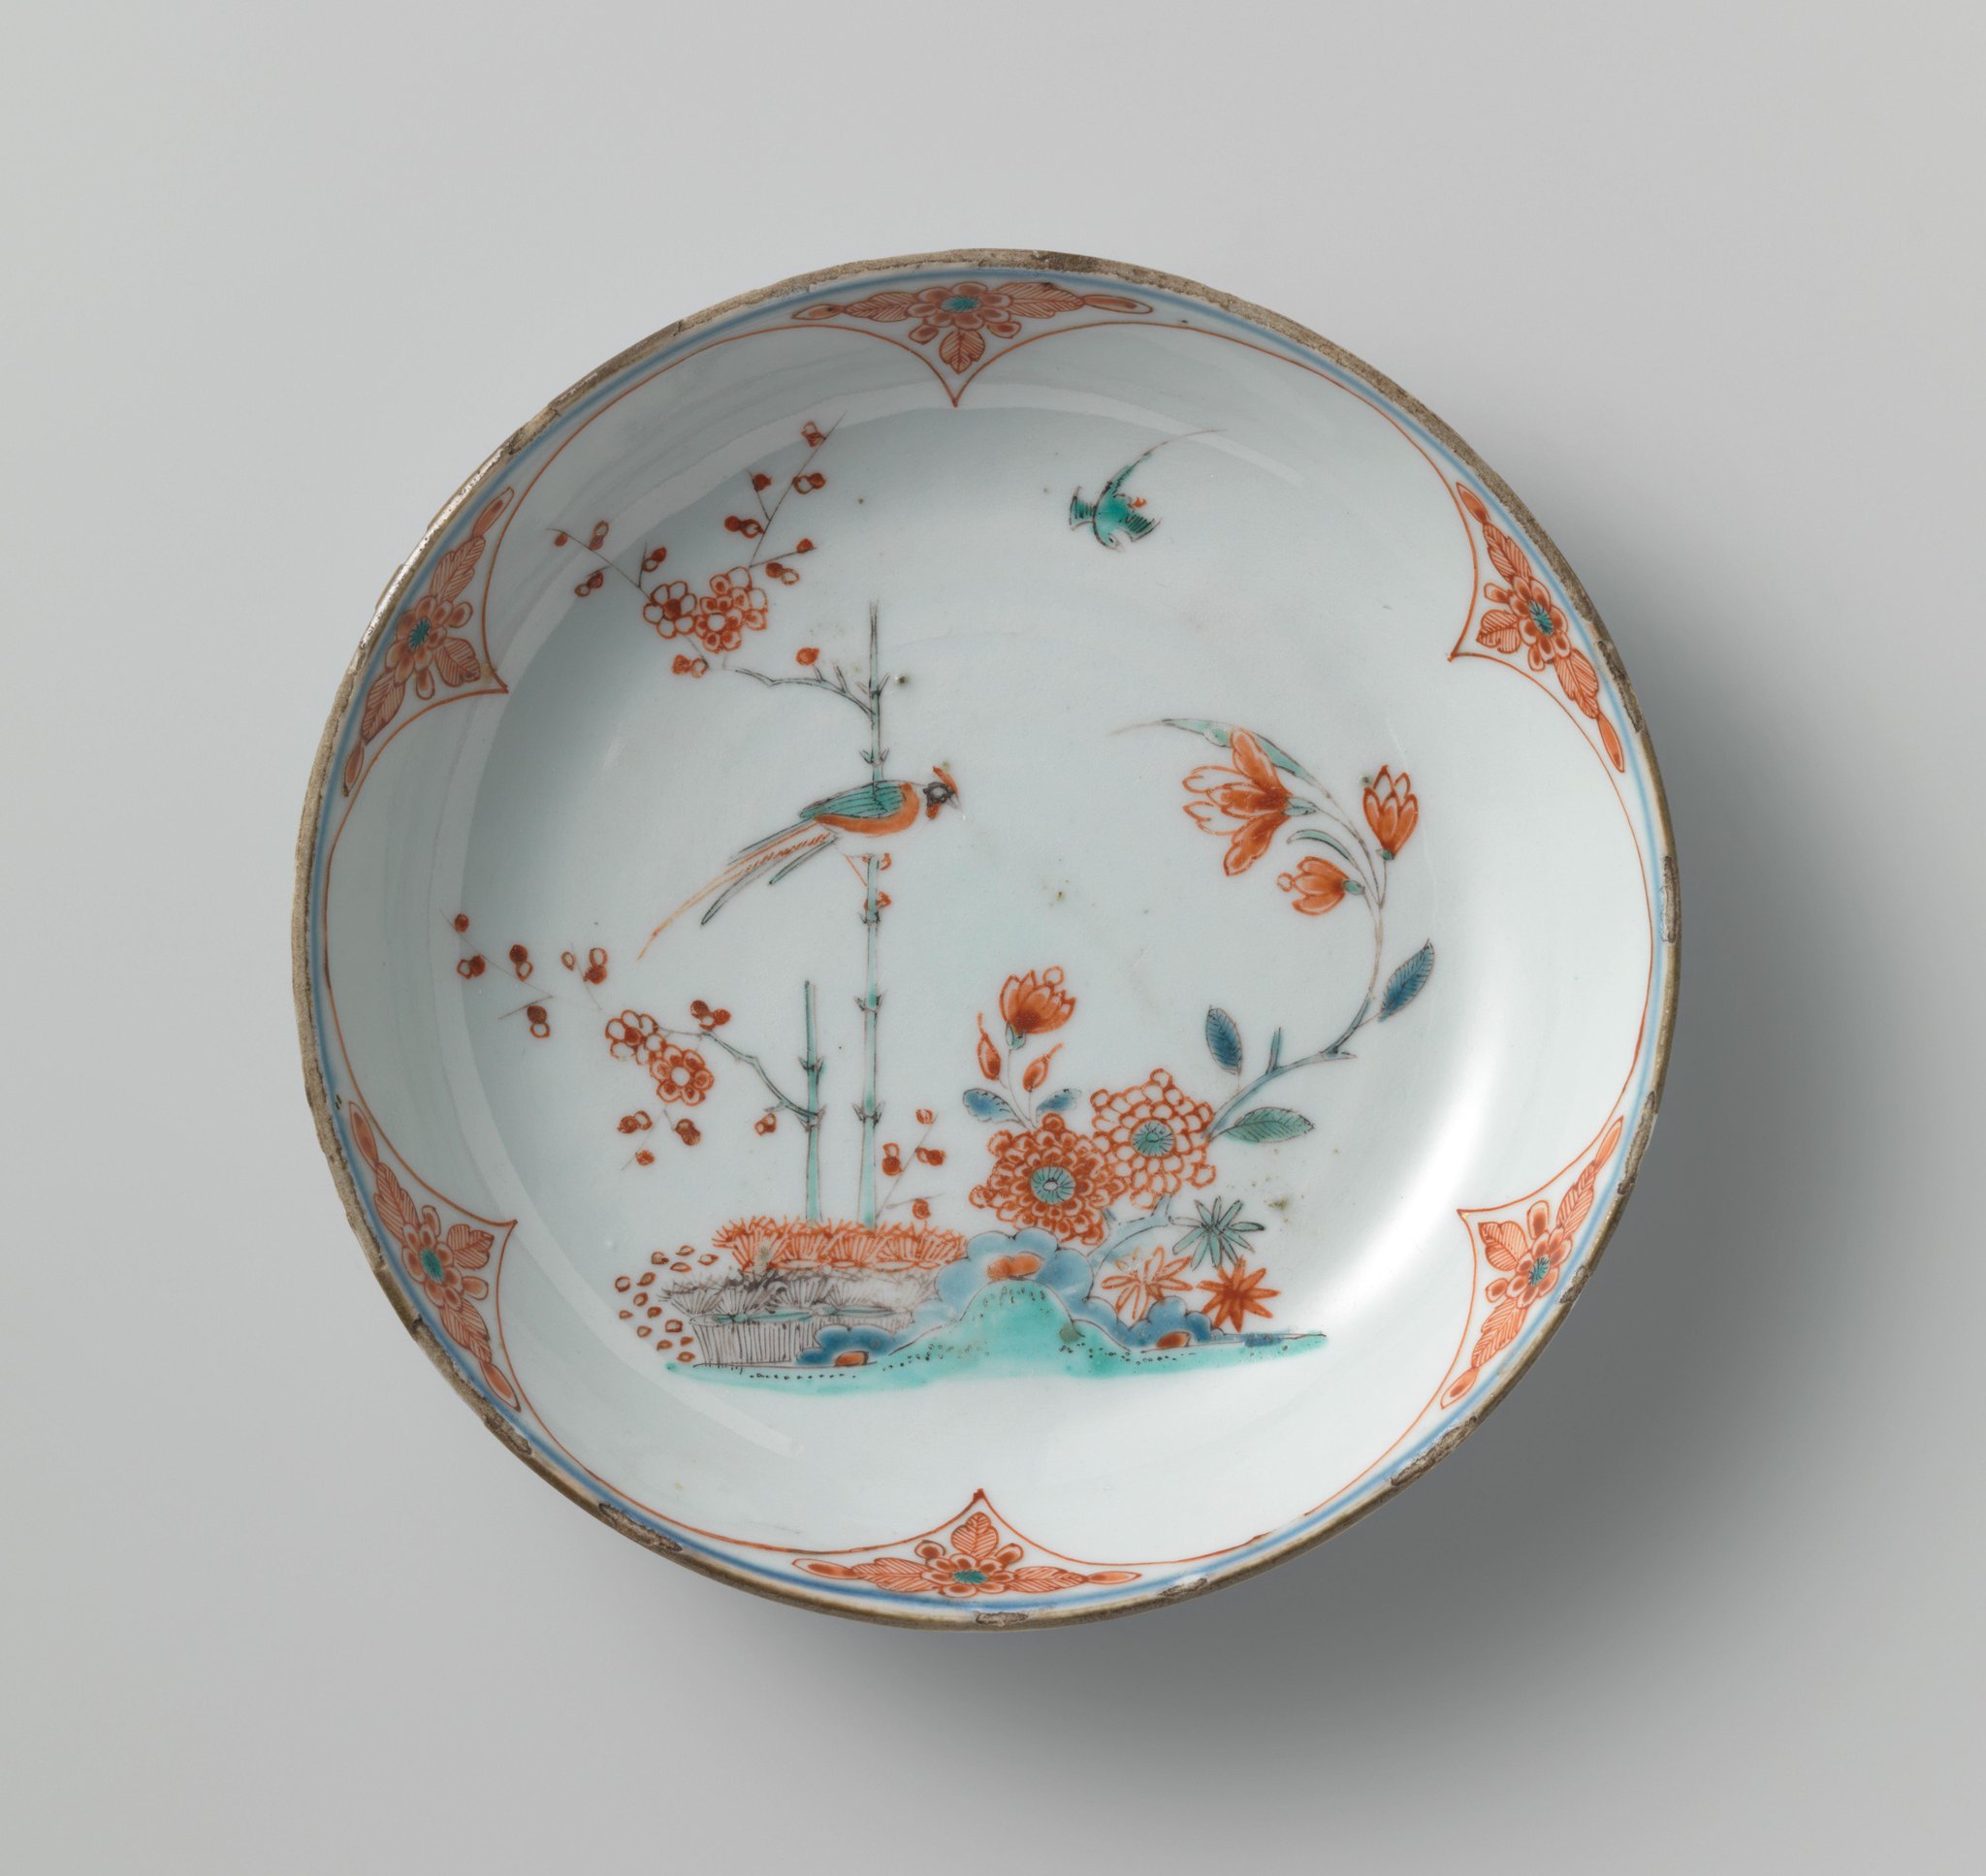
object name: dish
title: Saucer-dish with lotus scrolls and a pheasant on a prunus spray near flowering plants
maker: Anonymous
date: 1700-1724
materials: cobalt, glaze, gold, paint, porcelain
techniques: firing, gilding, turning, vitrification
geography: china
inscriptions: mark, label: ‘Collectie Westendorp/ 48’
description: Two saucer-dishes, c. 1700 - 1750.